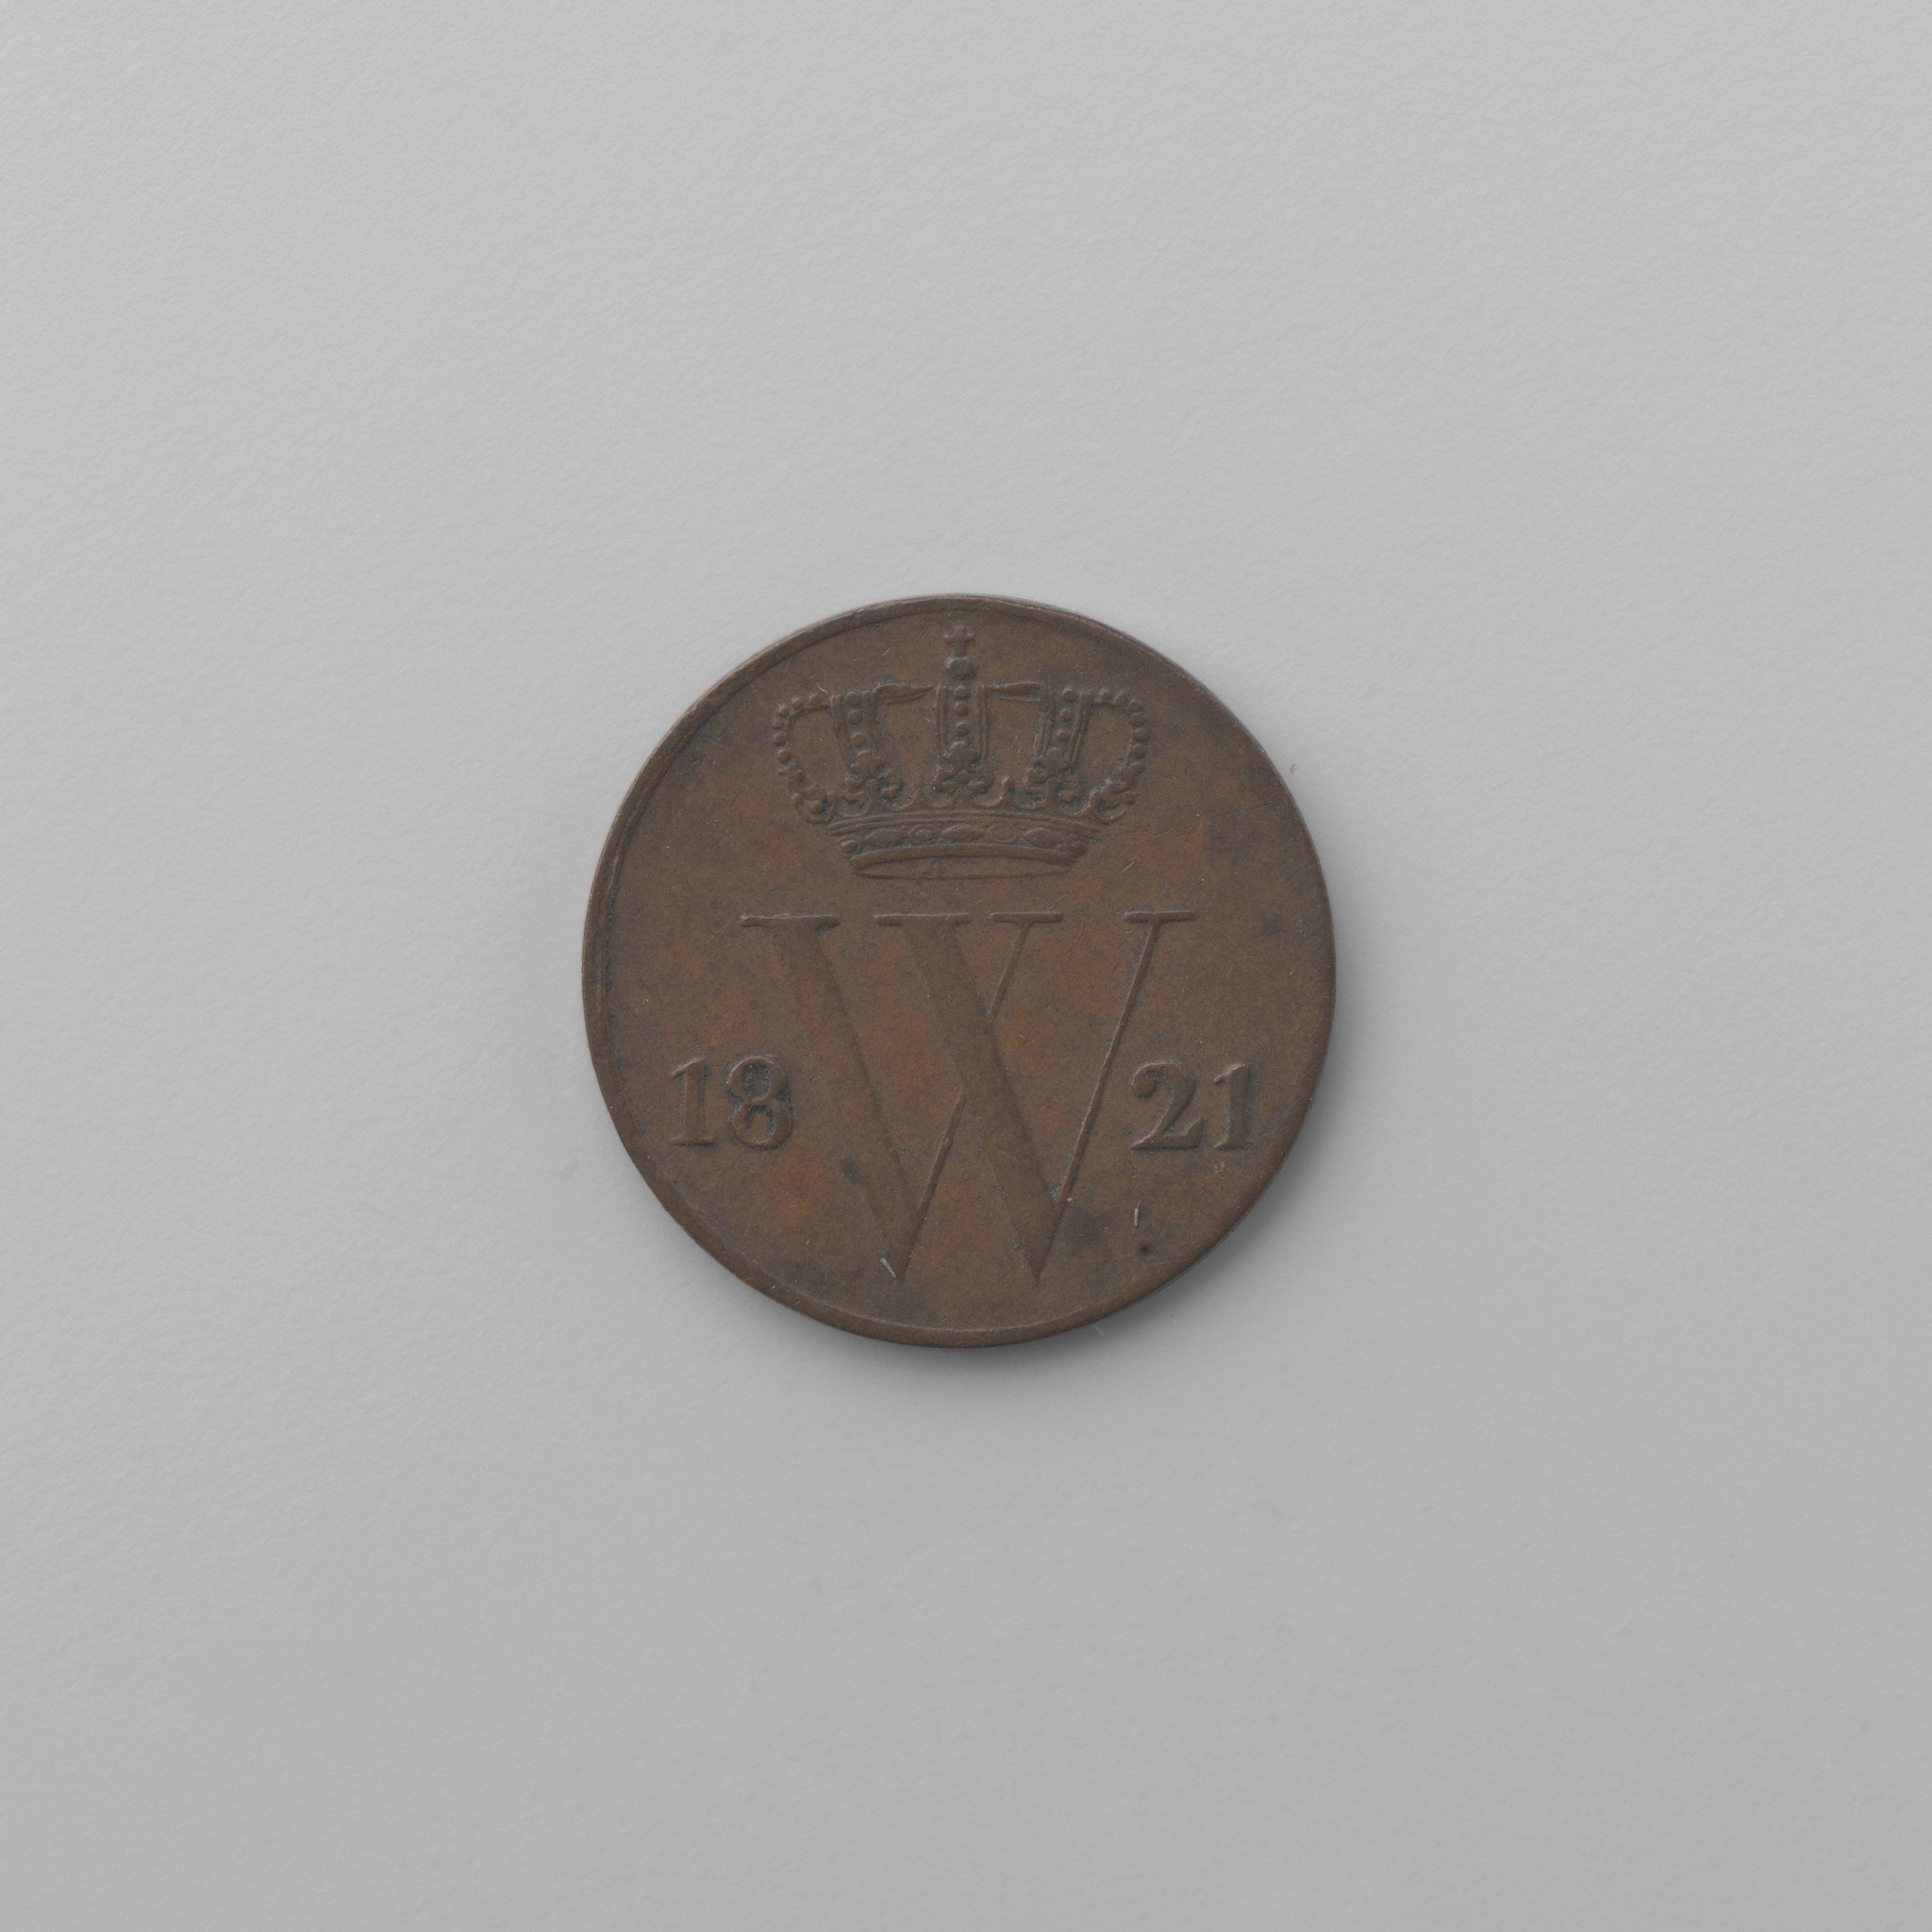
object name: coin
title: Nederland, ½ cent,1821 B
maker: william i of the netherlands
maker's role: koning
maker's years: 1772-1843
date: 1821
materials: copper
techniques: striking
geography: brussels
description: Koperen munt. Voorzijde: tussen jaartal gekroonde rechte letter W. Keerzijde: tussen waarde-aanduiding ½ C. gekroond rijkswapenschild. Gladde rand.